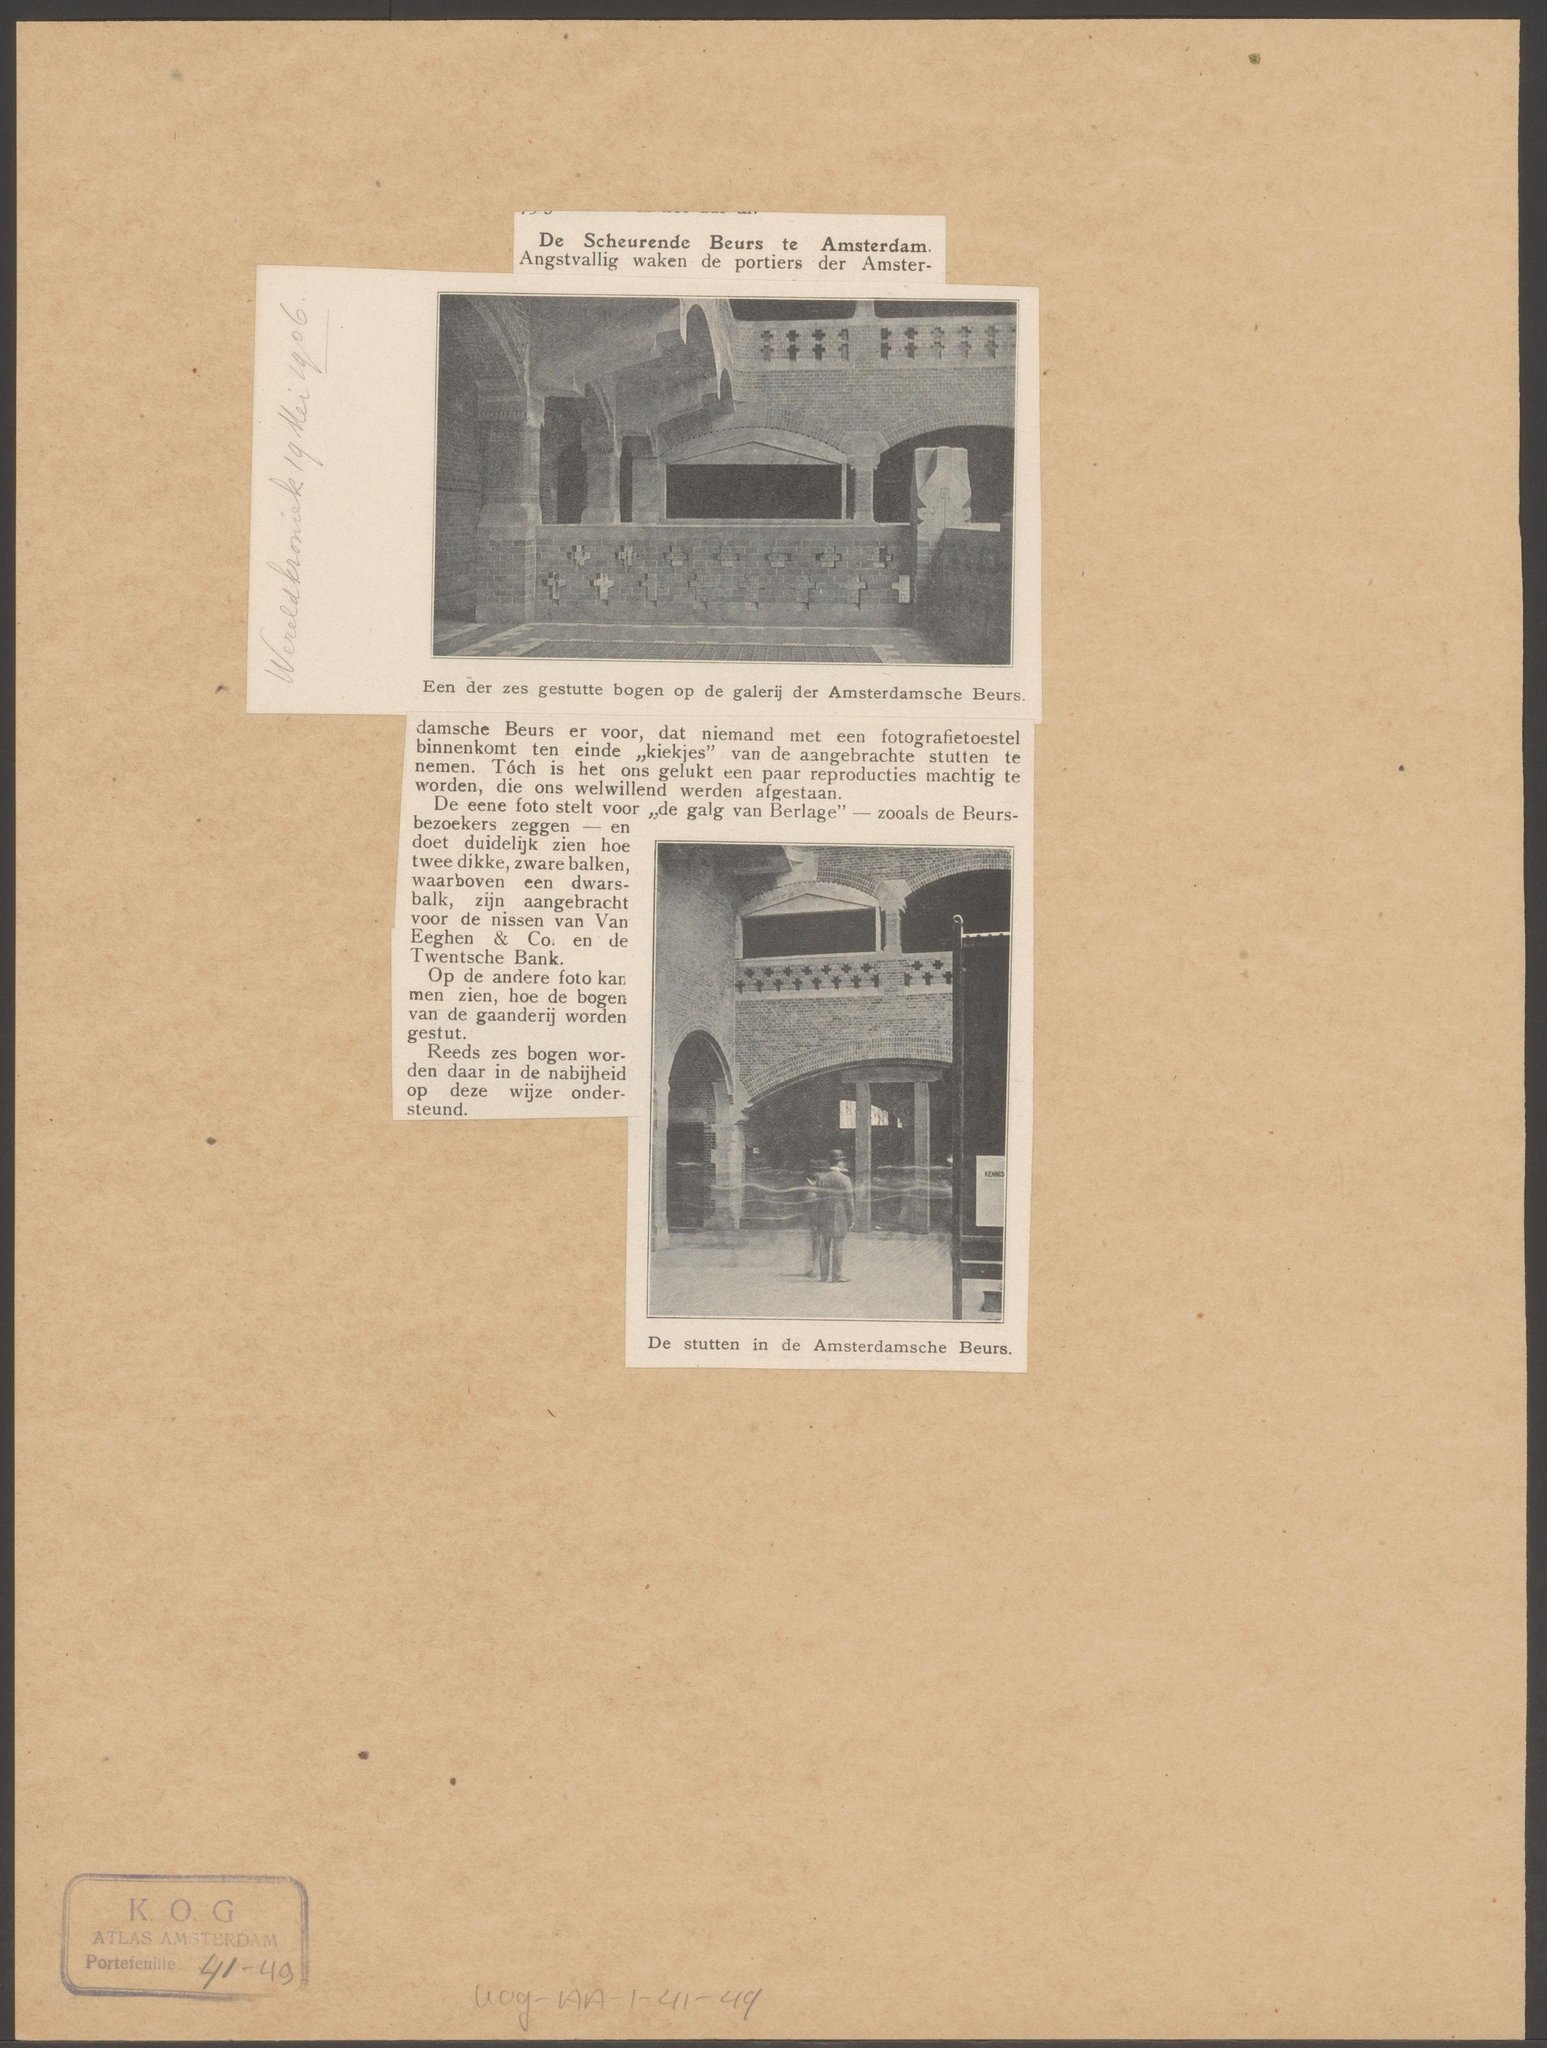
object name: photomechanical print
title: De scheurende Beurs te Amsterdam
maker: Anonymous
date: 1906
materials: paper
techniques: letterpress printing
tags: stock exchange, stock-market, amsterdam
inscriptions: collector's mark: Lugt 1461b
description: Onderwerpsrubriek binnen de Atlas Amsterdam: B. Beurs op het Damrak.